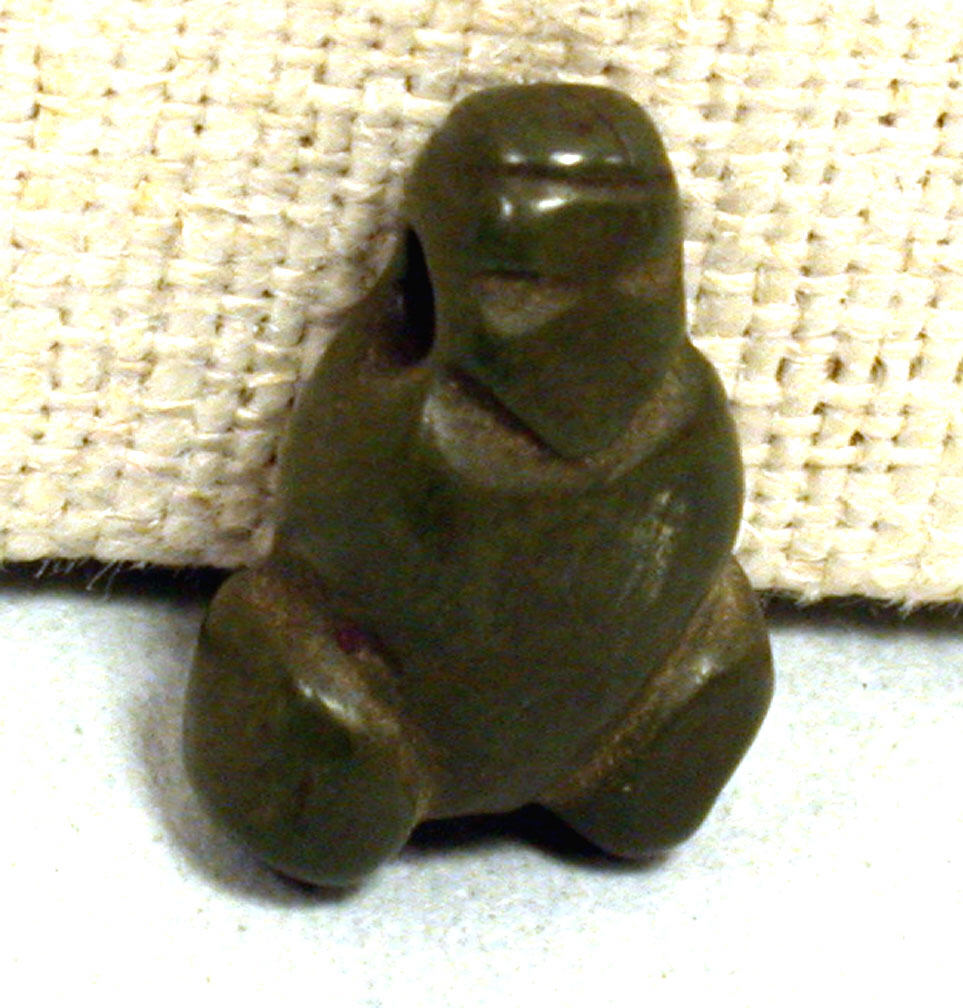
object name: pendant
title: Stone Figure Pendant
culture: costa rican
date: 801-1500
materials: stone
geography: costa rica